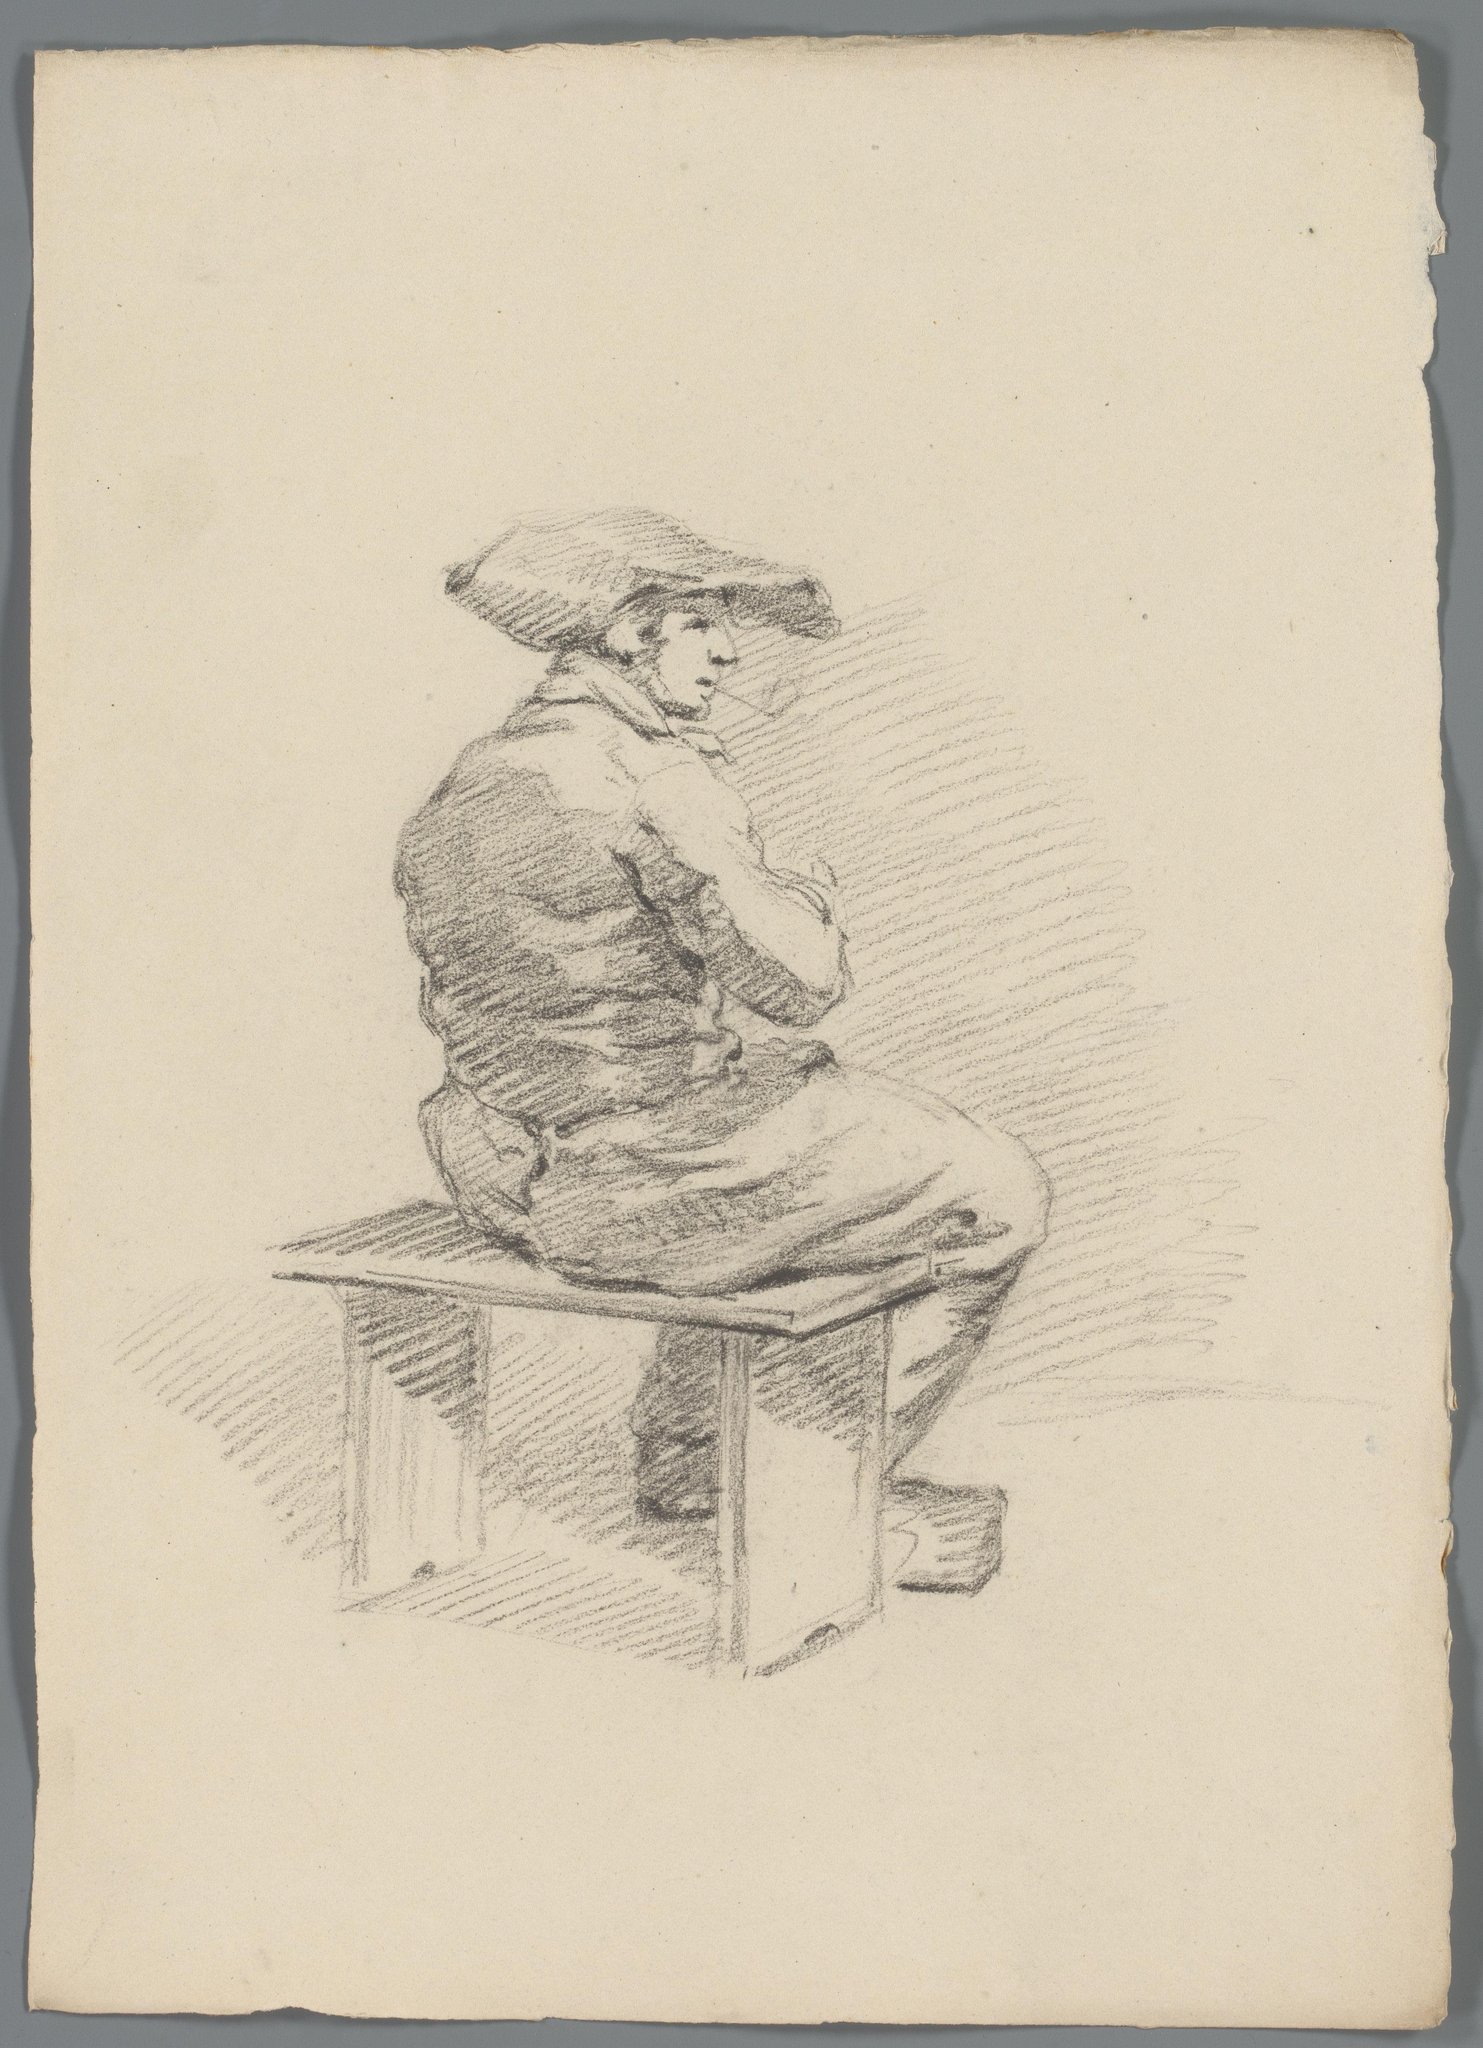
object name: drawing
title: Zittende man met pijp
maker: Anonymous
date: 1820-1830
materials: chalk, paper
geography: the hague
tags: sitting figure, adult man, pipe ~ tobacco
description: Tekeningen waarschijnlijk ontstaan bij het Haagse kunstgenootschap ‘Tot Nut der Tekenkunst’, waar twee keer per week tekenavonden werden georganiseerd met geklede modellen.